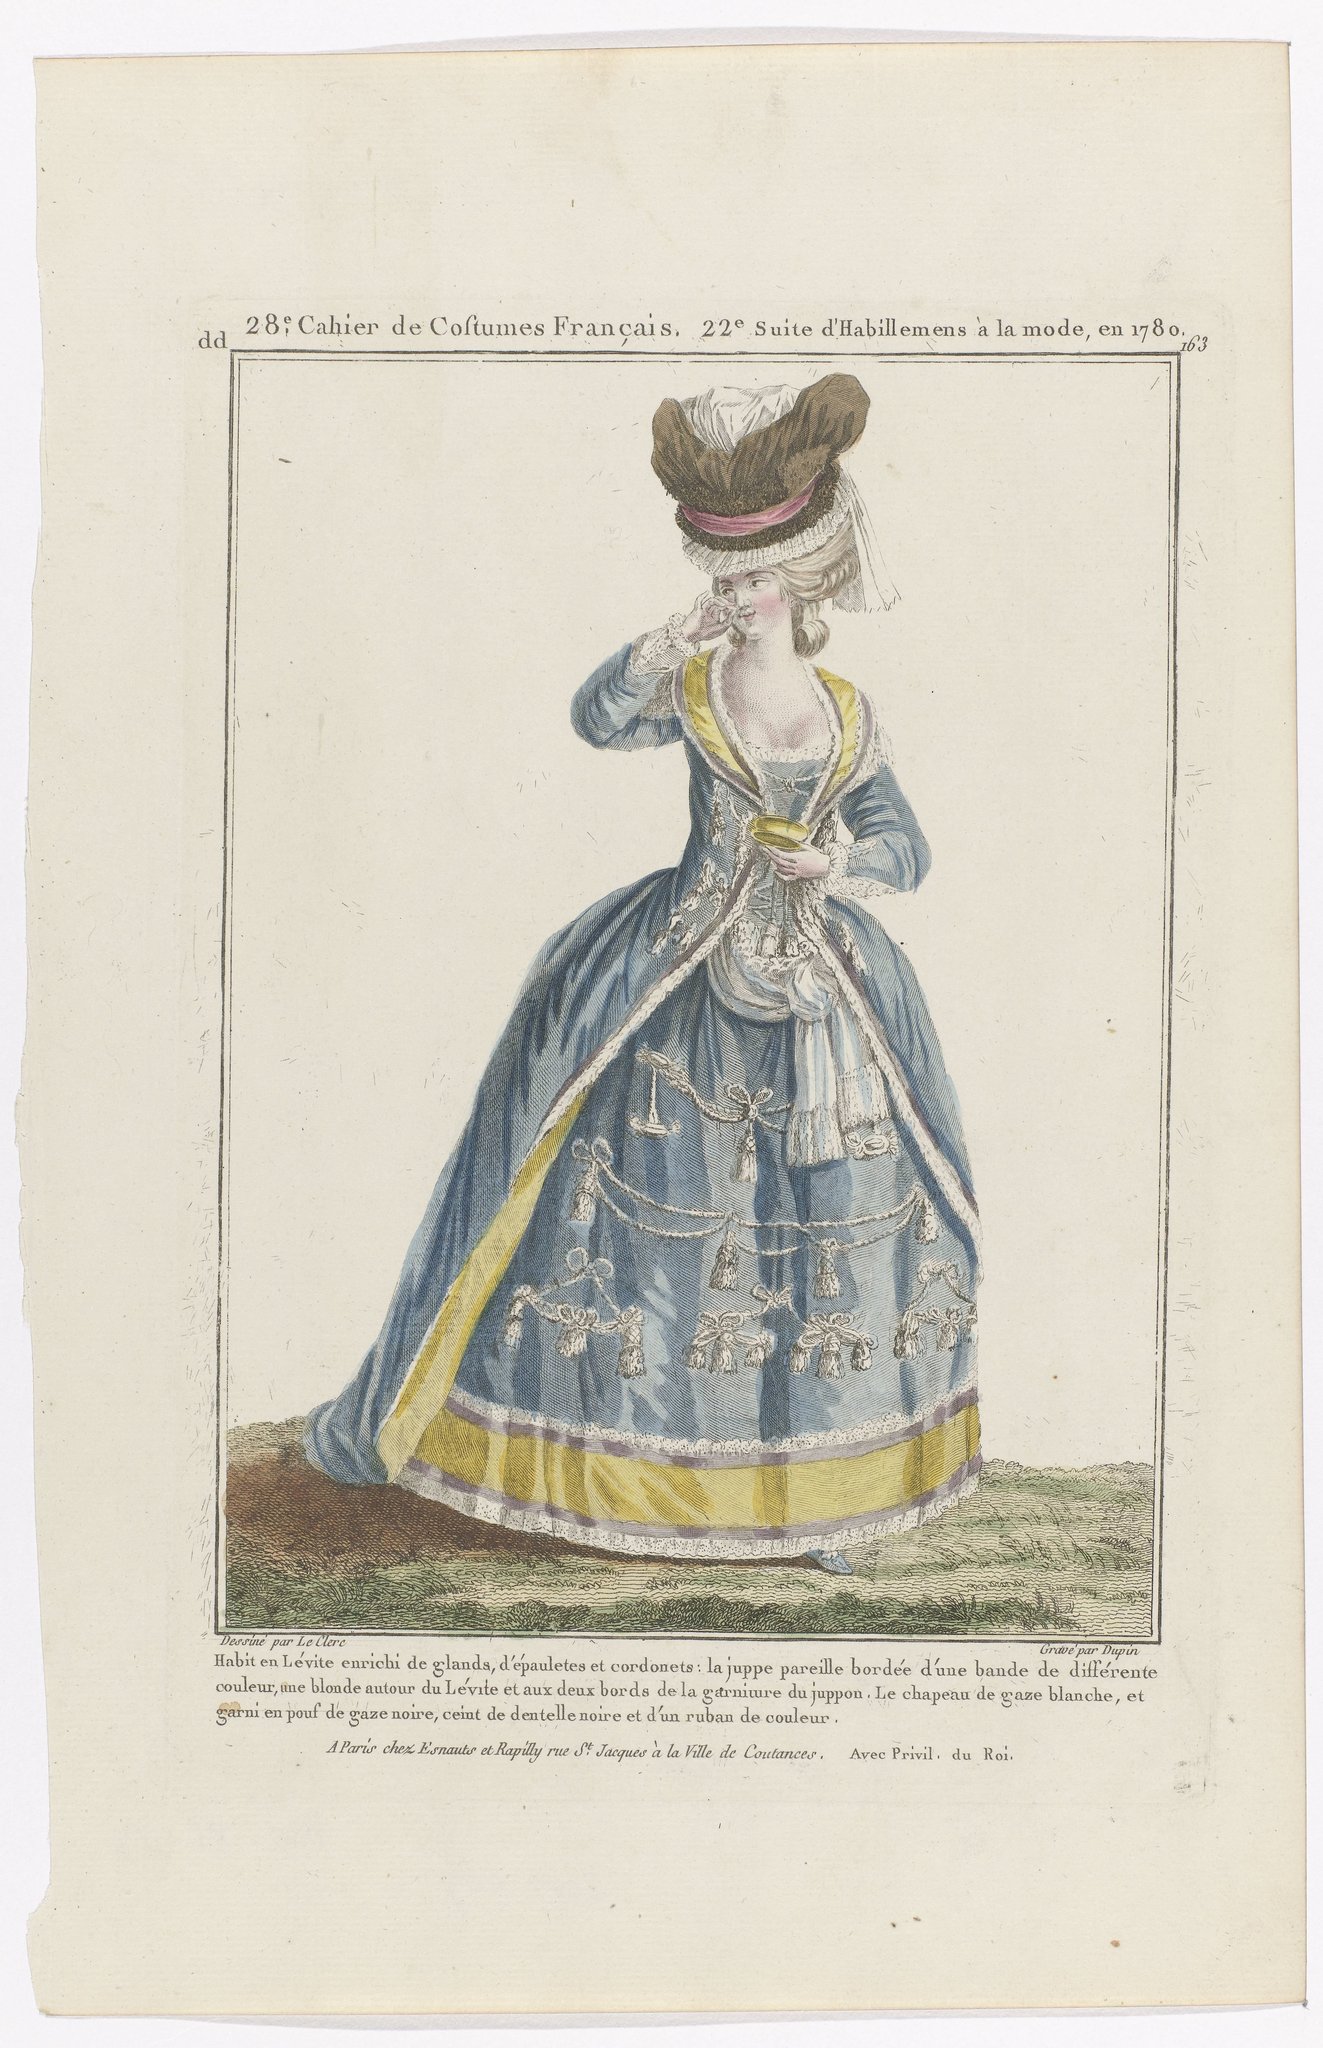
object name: fashion print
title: Gallerie des Modes et Costumes Français, 1780, dd 163 : Habit en Lévit (...)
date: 1780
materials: paper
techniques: engraving, hand coloring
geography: paris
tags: clothing for the upper part of the body (shawl) (+ women's clothes), snuff-box, ornamental parts of clothing (+ women's clothes), border, ribbon, braid (+ women's clothes), lace (+ women's clothes), dress, gown: robe à la lévite (+ women's clothes), fashion plates, head-gear: hat (+ women's clothes), skirt (+ women's clothes)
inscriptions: caption: ‘Habit en Lévite enrichi de glands, d'épauletes et cordonets: la juppe pareille bordée d'une bande de différente couleur, une blonde autour du Lévite et aux deux bords de la garniture de juppon. Le chapeau de gaze blanche, et garni en pouf de gaze noir, veint de dentelle noire et d'un ruban de couleur.’, title: ‘28e Cahier de Costumes Français,22e Suite d'Habillemens à la mode, en 1780.’, address: ‘A Paris chez Esnauts et Rapilly rue St. Jacques à la Ville de Coutances. A.P.D.R.’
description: Vrouw met snuifdoos in de hand. Zij draagt een 'habit en Lévite' (jasjurk) versierd met koorden, epauletten en kwasten. De bijbehorende rok is afgezet met een band van een andere kleur. Rond de Lévite en aan weerszijden van de rok is 'blonde' of kloskant aangebracht. Op het hoofd een hoed van witte tule, versierd met een pouf van zwarte tule en linten van kant. Om het middel een gestrikte sjaal met franjes. Prent uit de serie dd. 28e Cahier de Costumes Français, 22e Suite d'Habillemens à la mode en 1780, Gallerie des Modes et Costumes Français.